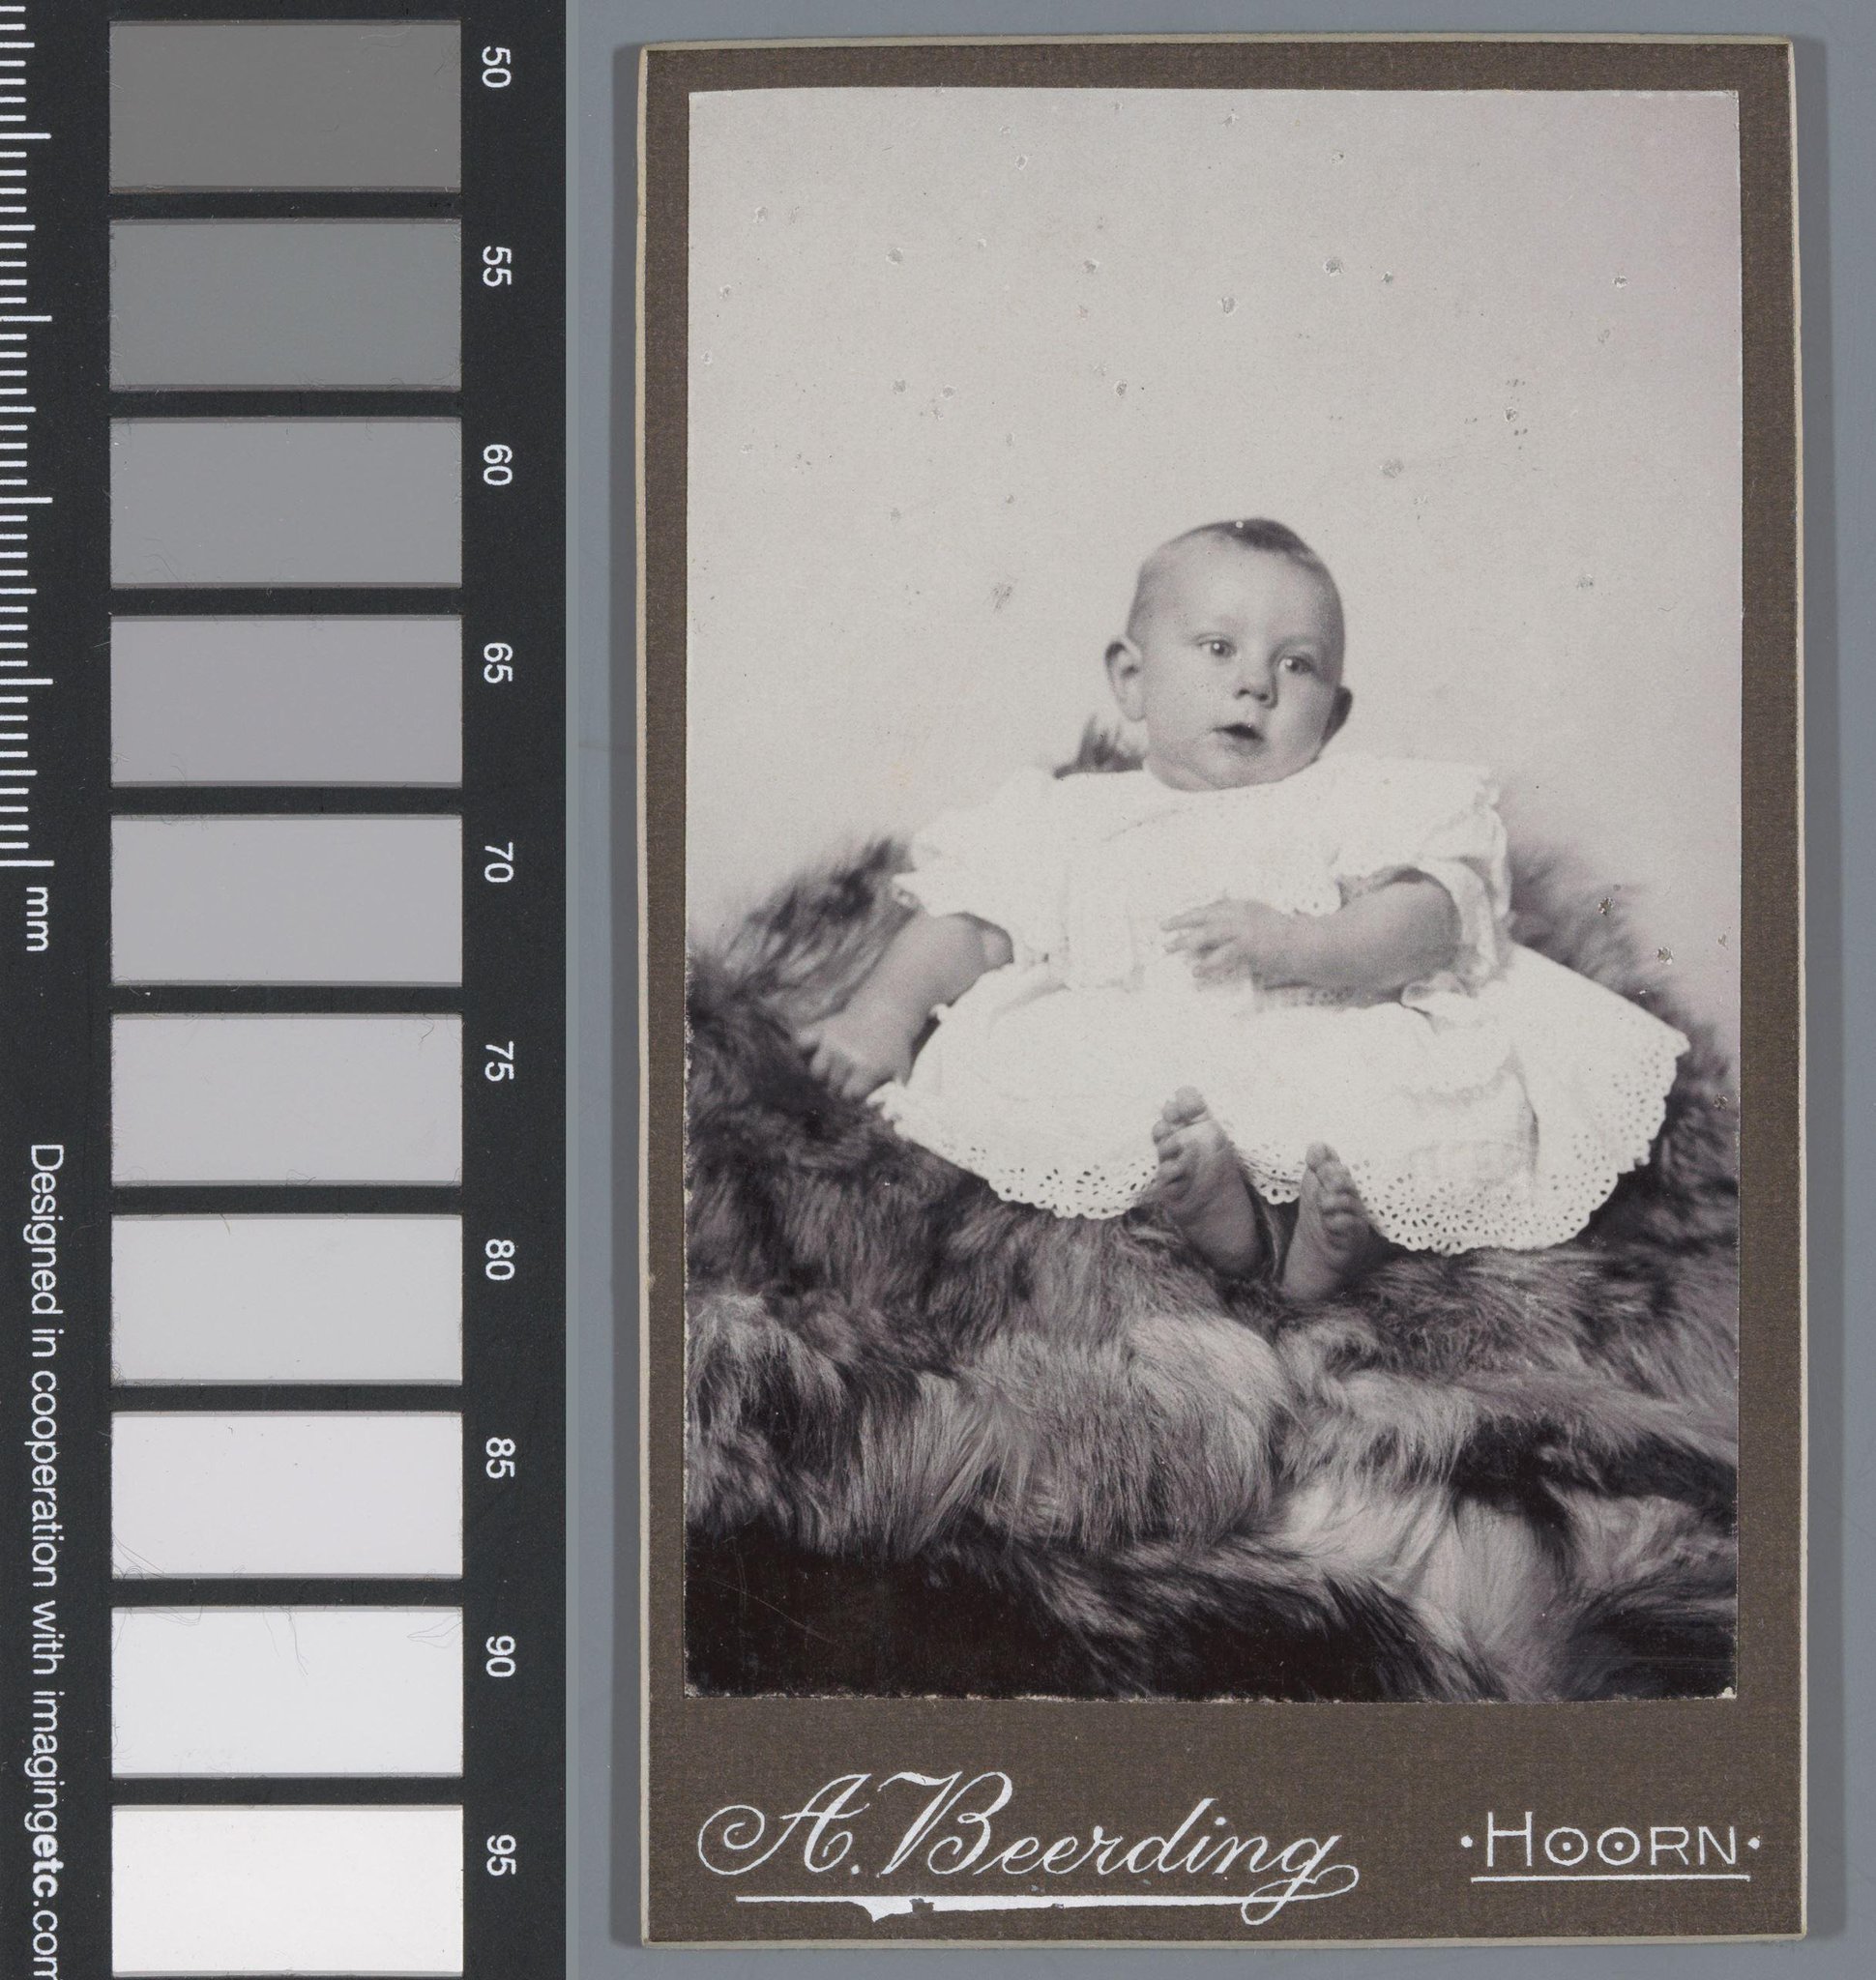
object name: carte de visite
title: Portret van Pieter Haan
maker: alida beerding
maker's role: fotograaf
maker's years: 1875-1949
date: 1912-1928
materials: cardboard, photographic support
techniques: collodion silver print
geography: hoorn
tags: historical persons, infant, baby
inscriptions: inscription: ‘Pieter Haan’